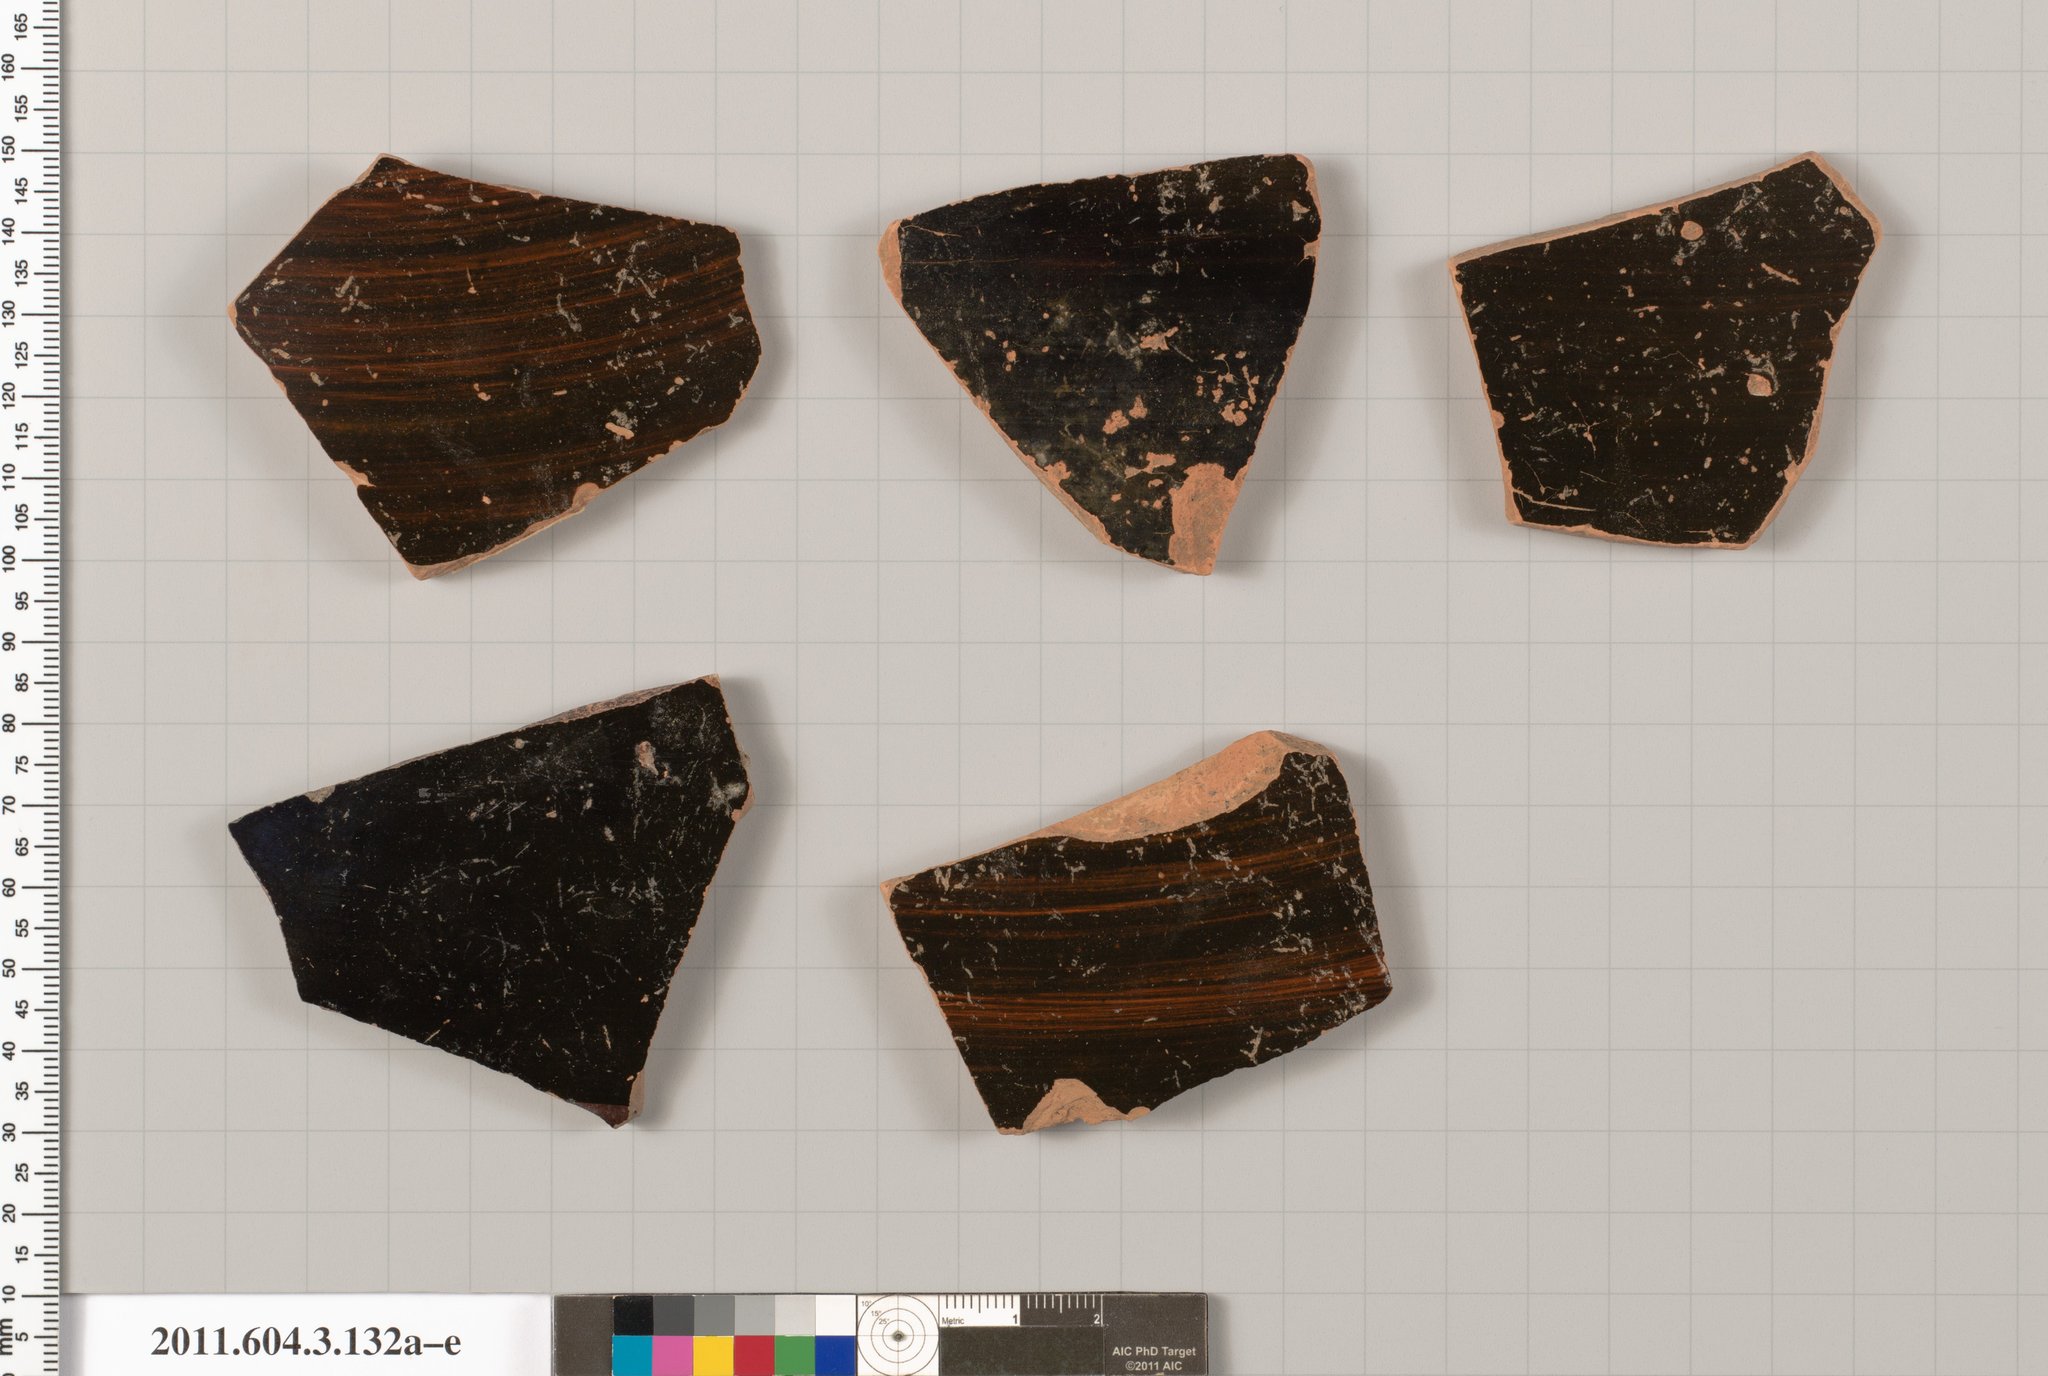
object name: amphora fragment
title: Terracotta fragments of amphorae (jars)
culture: greek, attic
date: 600-468 BCE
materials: terracotta